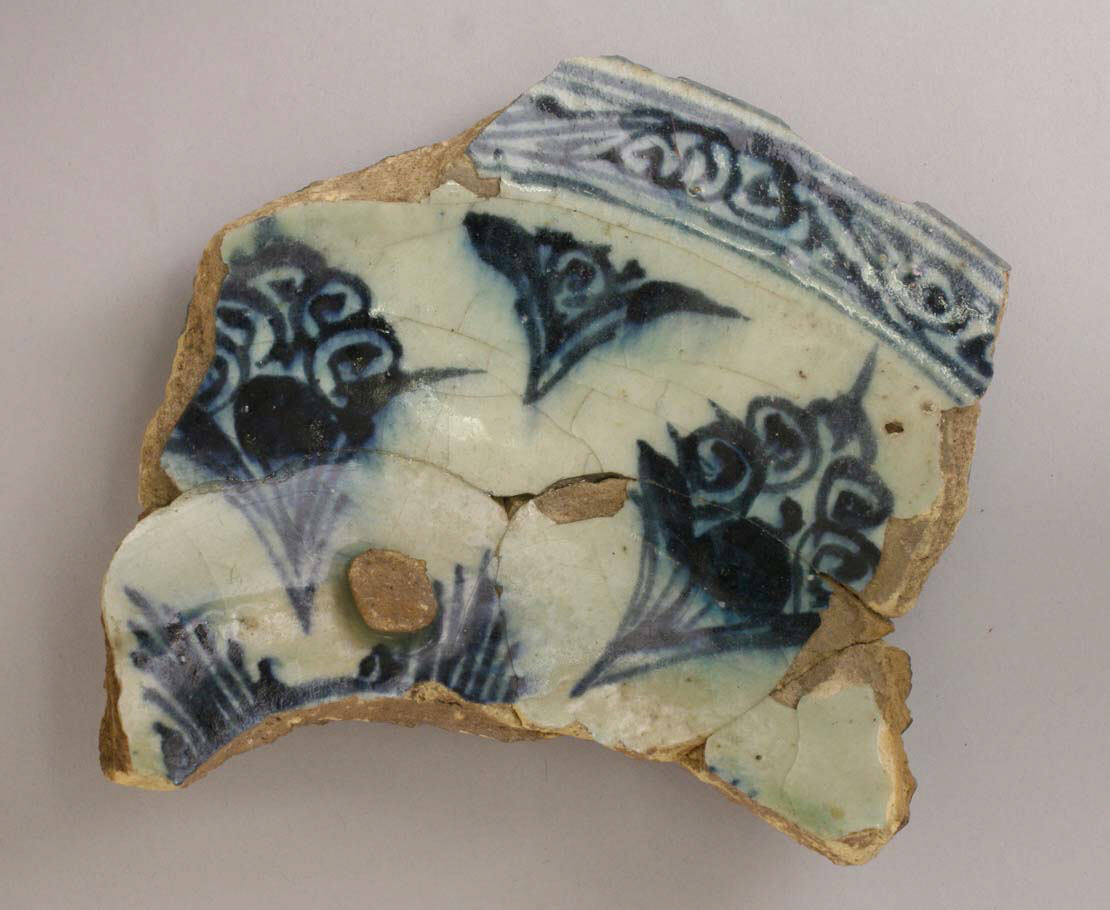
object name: ceramic fragment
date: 1301-1400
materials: glaze, stonepaste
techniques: painting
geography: syria